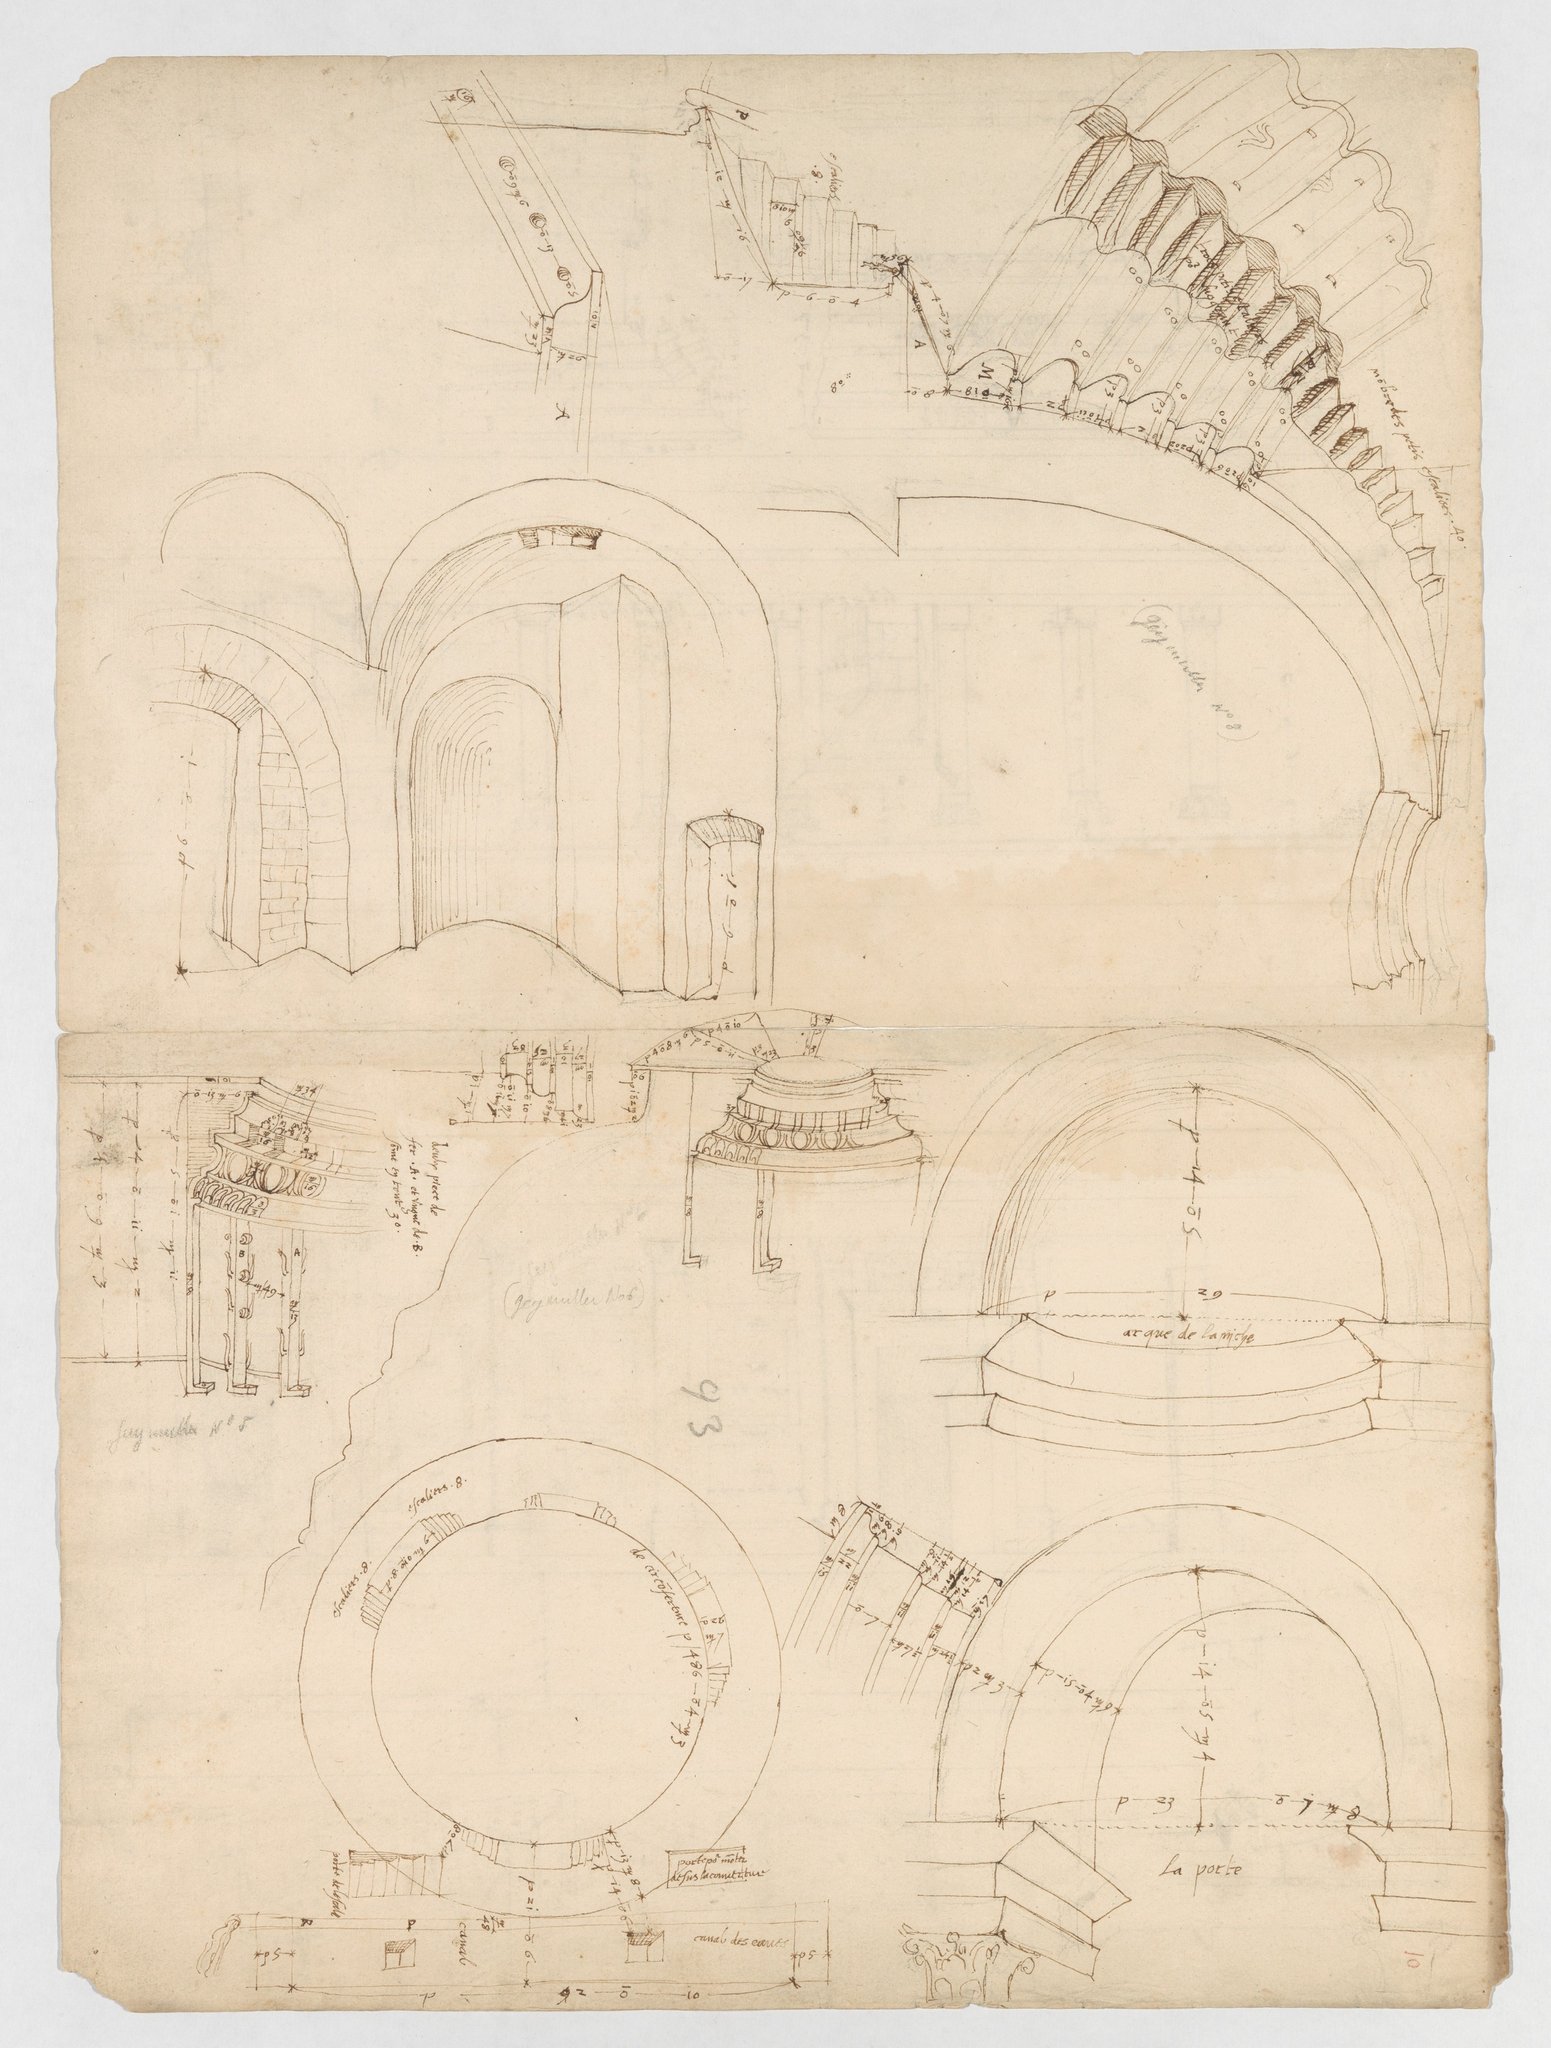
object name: collection ornament architecture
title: Pantheon, dome, section details; alcove, section and details (recto) Pantheon, rotonda, upper order, elevation and details (verso)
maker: anonymous, french, 16th century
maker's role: draftsman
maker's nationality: french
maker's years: 1500-1600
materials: chalk, ink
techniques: incising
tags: architecture